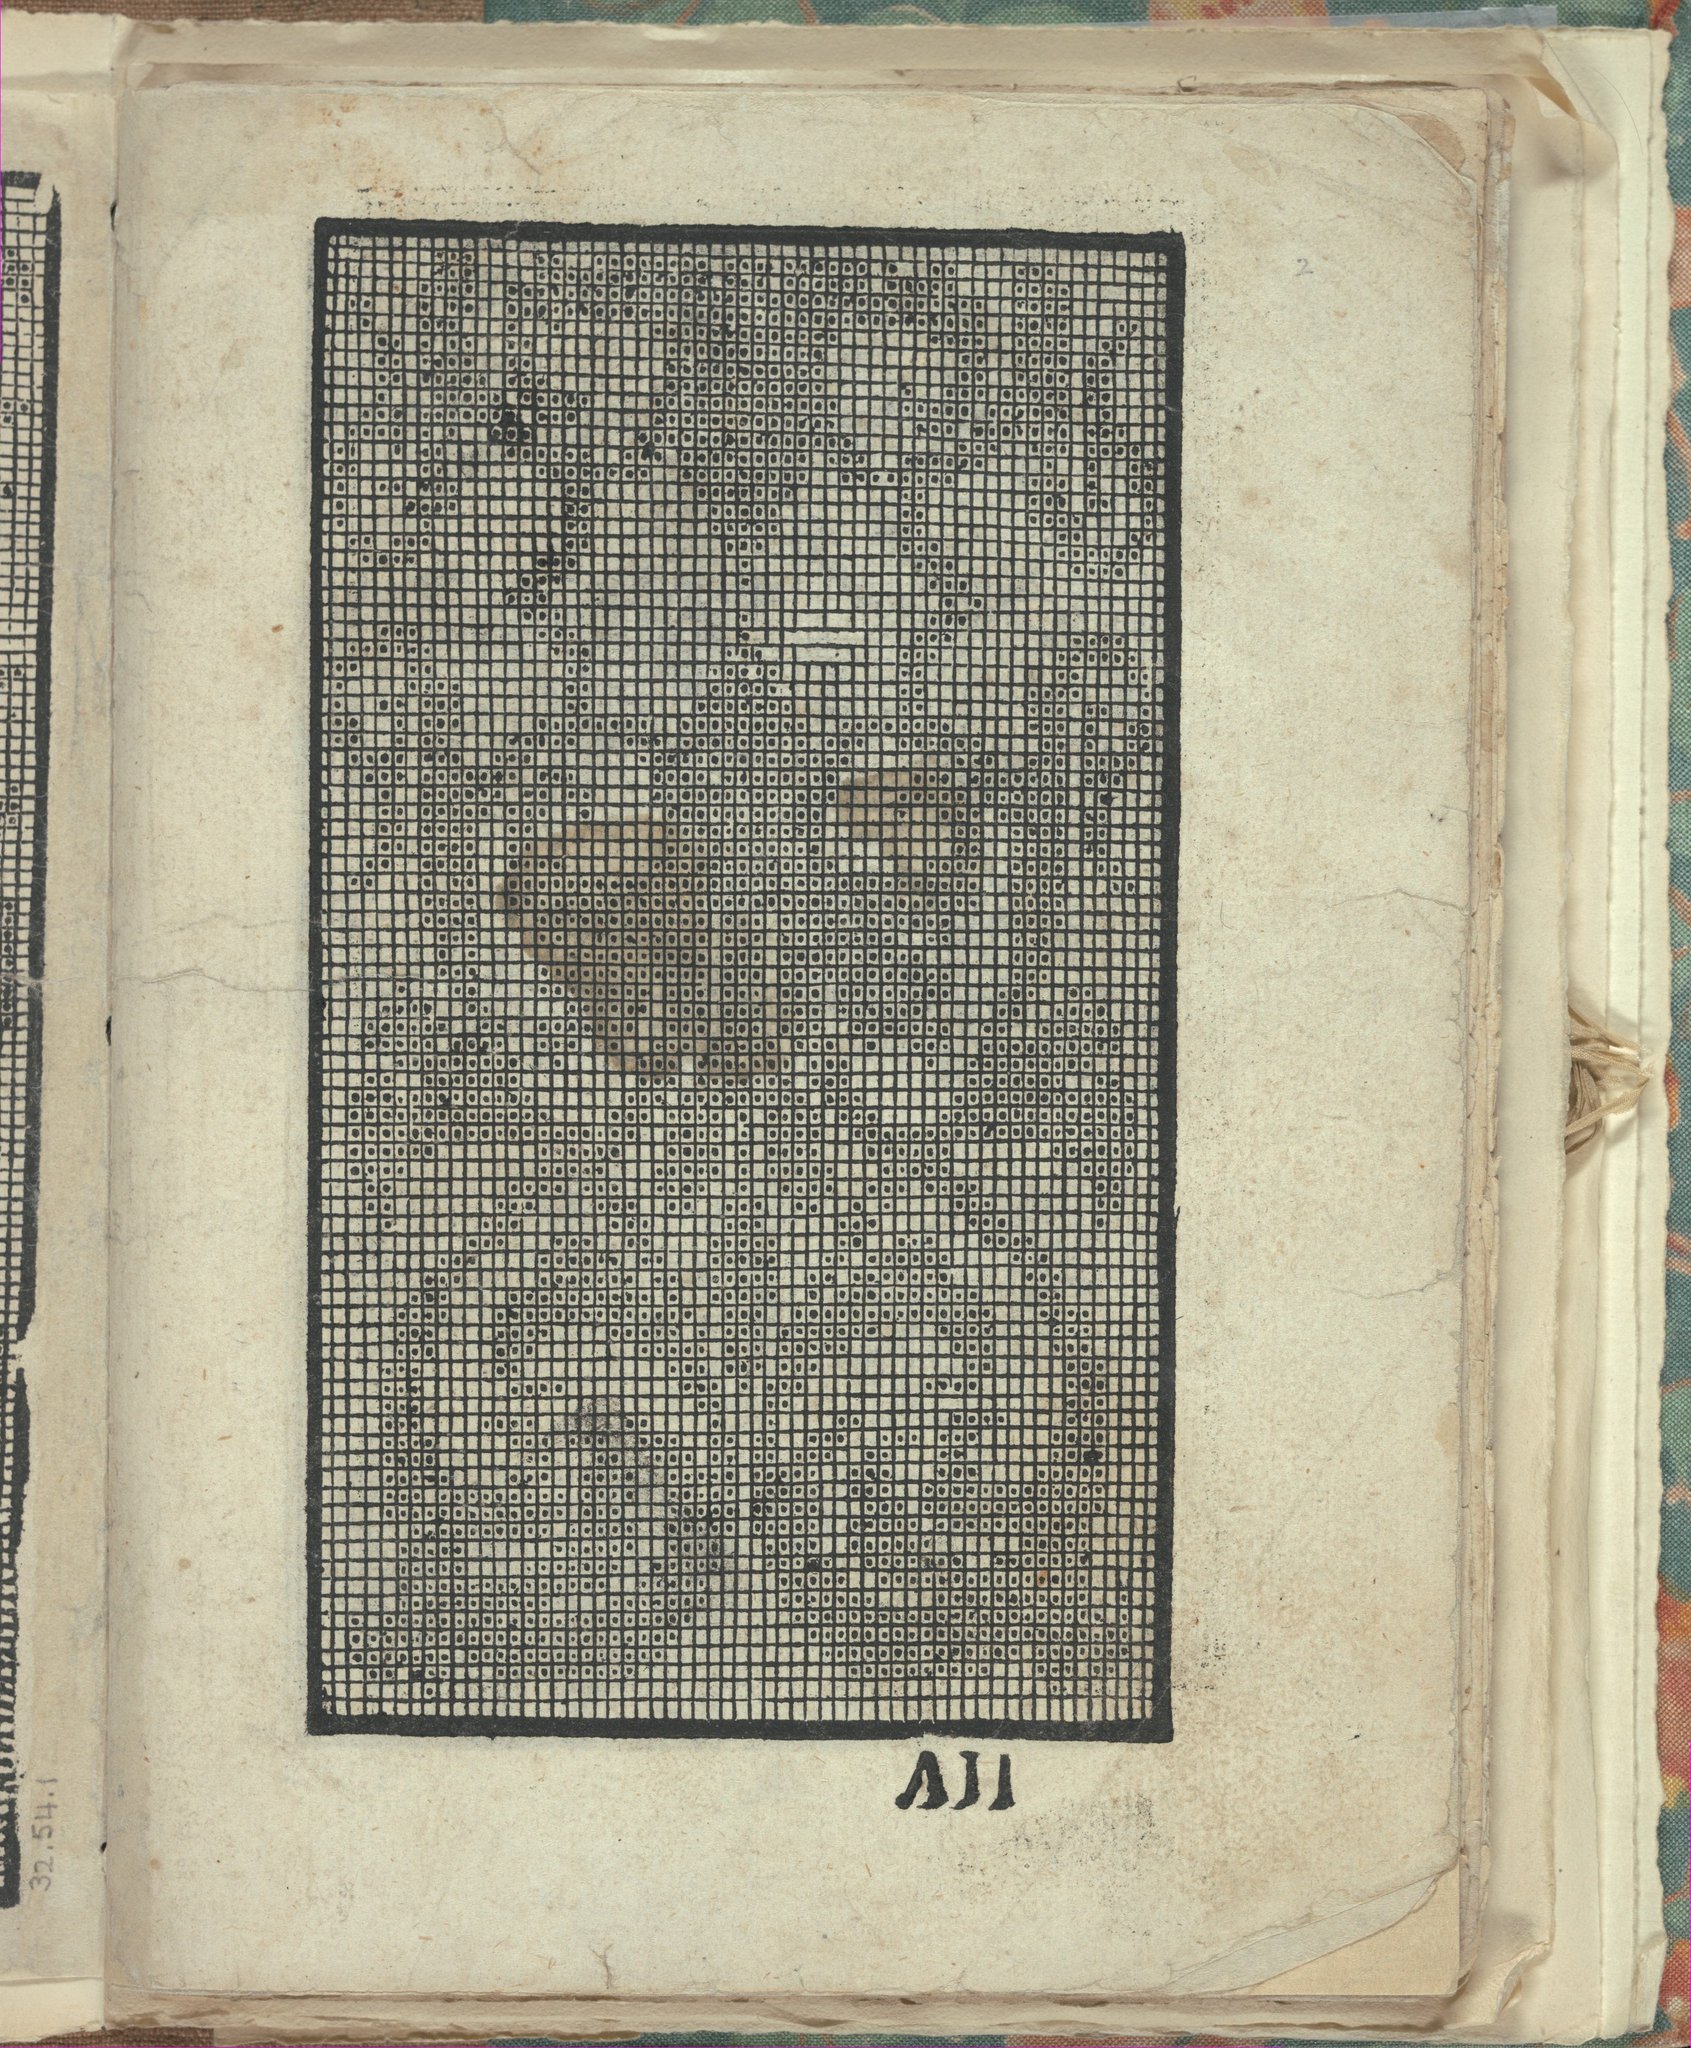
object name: book print ornament architecture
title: Opera Nova Universali intitulata Corona di racammi, page 2 (recto)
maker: giovanni andrea vavassore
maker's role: publisher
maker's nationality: italian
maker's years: 1530-1573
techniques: woodcut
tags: ornament